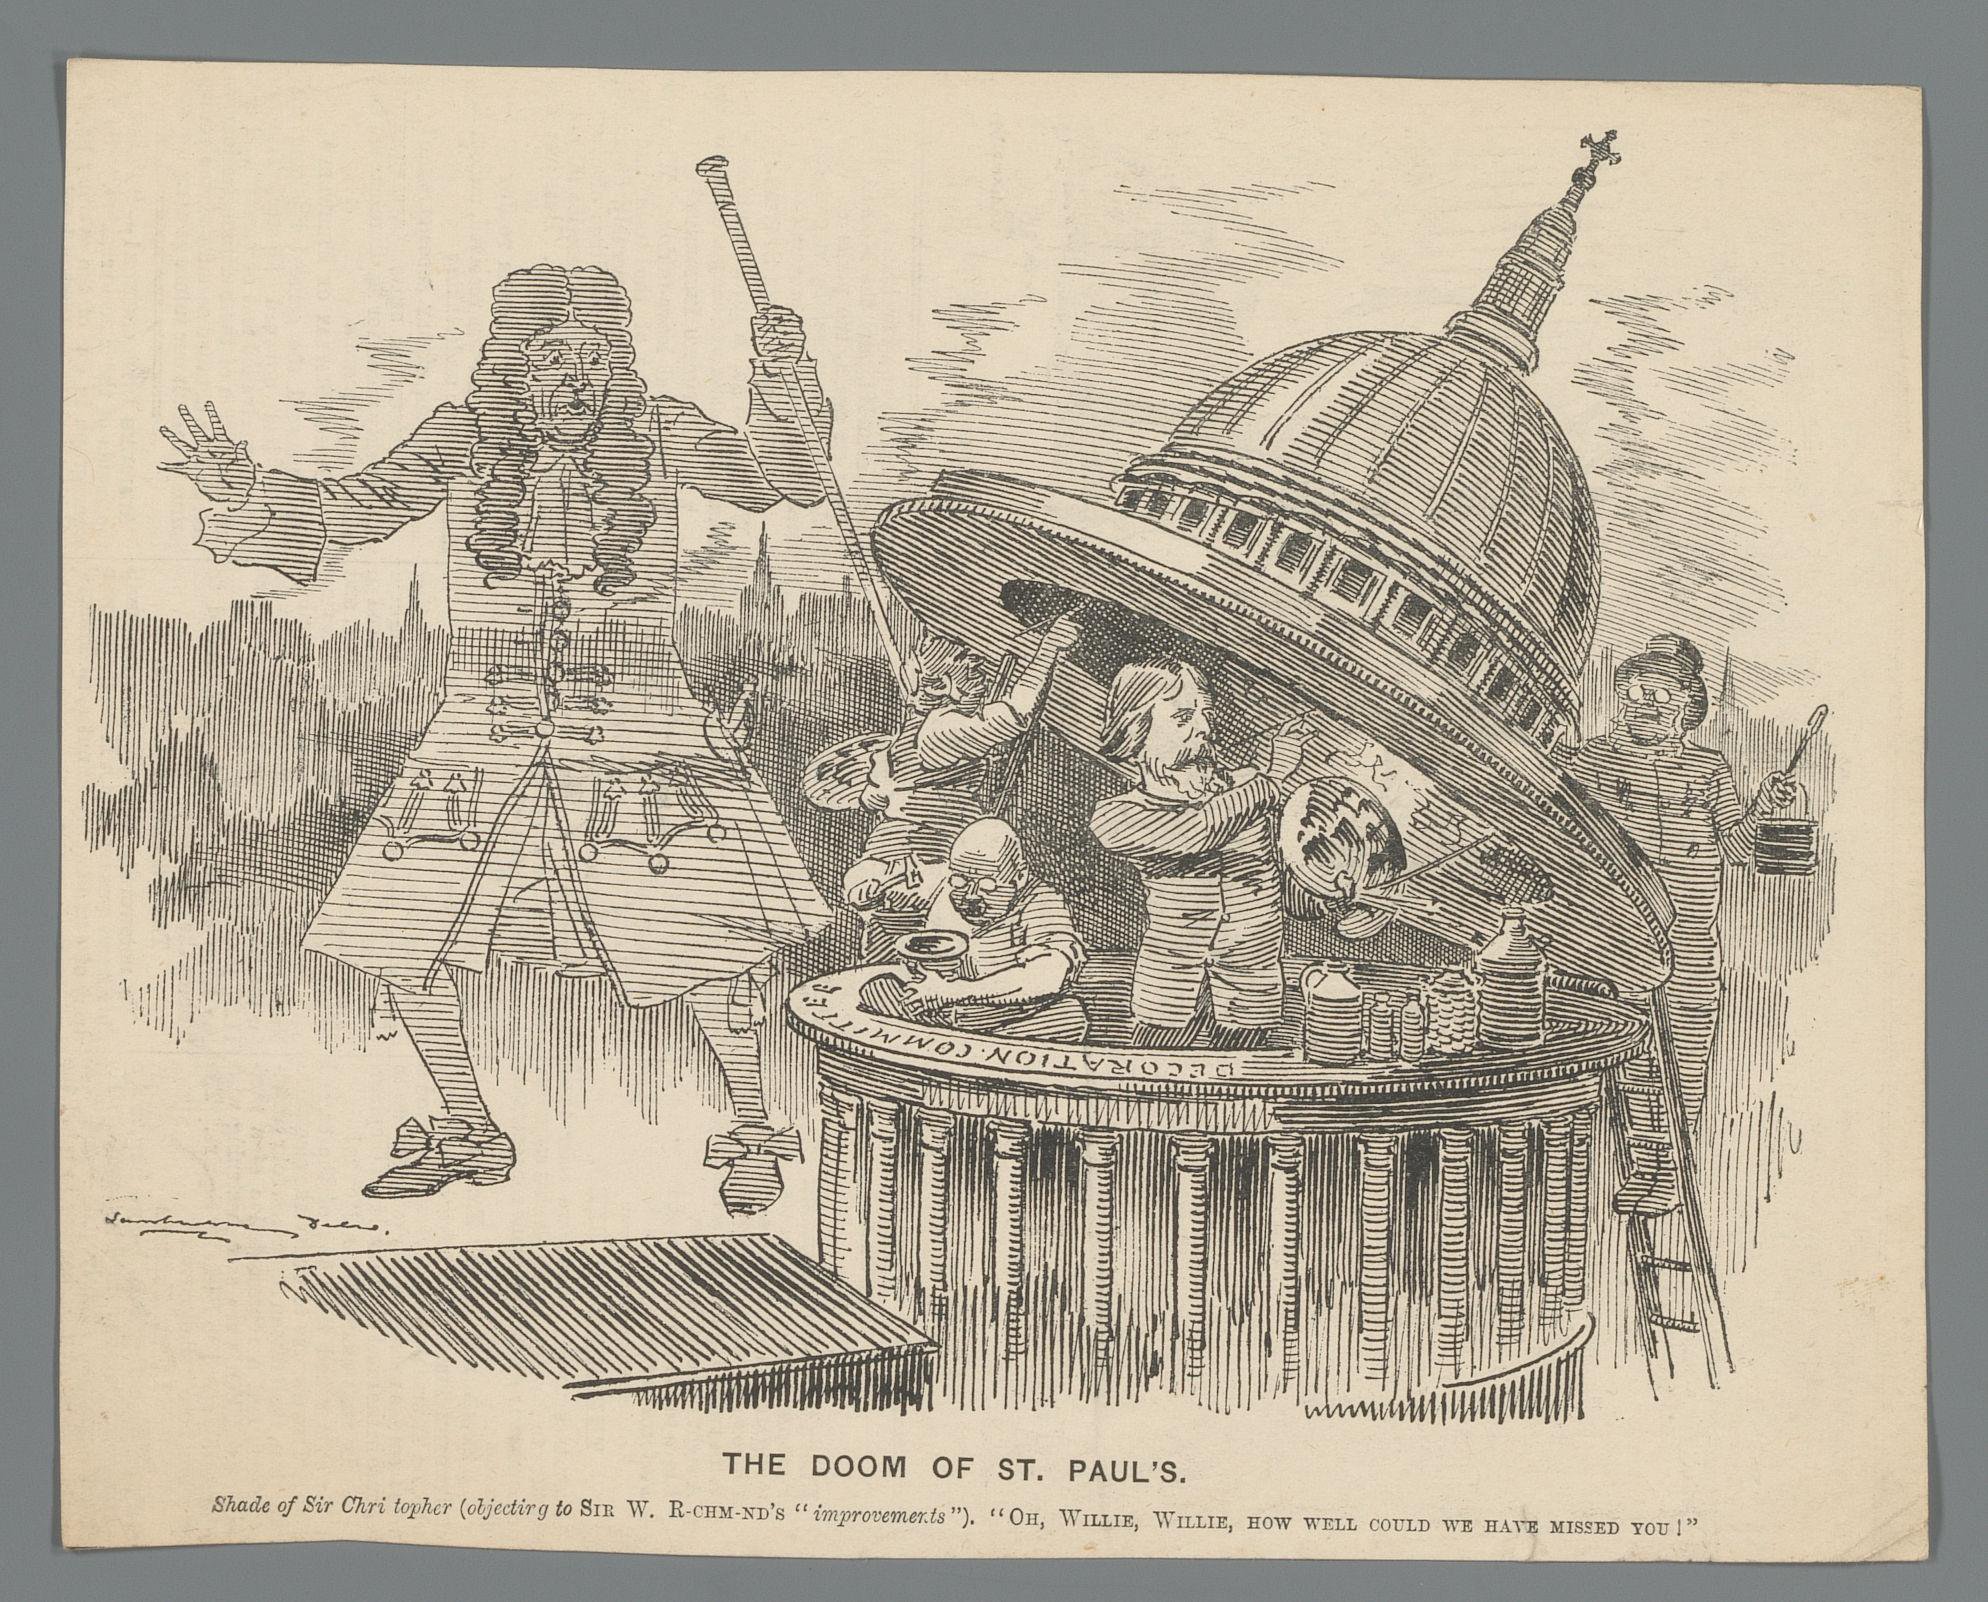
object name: print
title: St Paul's kathedraal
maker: edward linley sambourne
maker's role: draughtsman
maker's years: 1844-1910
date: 1899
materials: paper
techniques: line block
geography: england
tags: christopher wren, political caricatures and satires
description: Metselen aan de koepel van St Paul's Cathedral in Londen. Christopher Wren kijkt verschrikt toe. Politieke spotprent uit het Engelse satirische tijdschrift Punch, 1899.